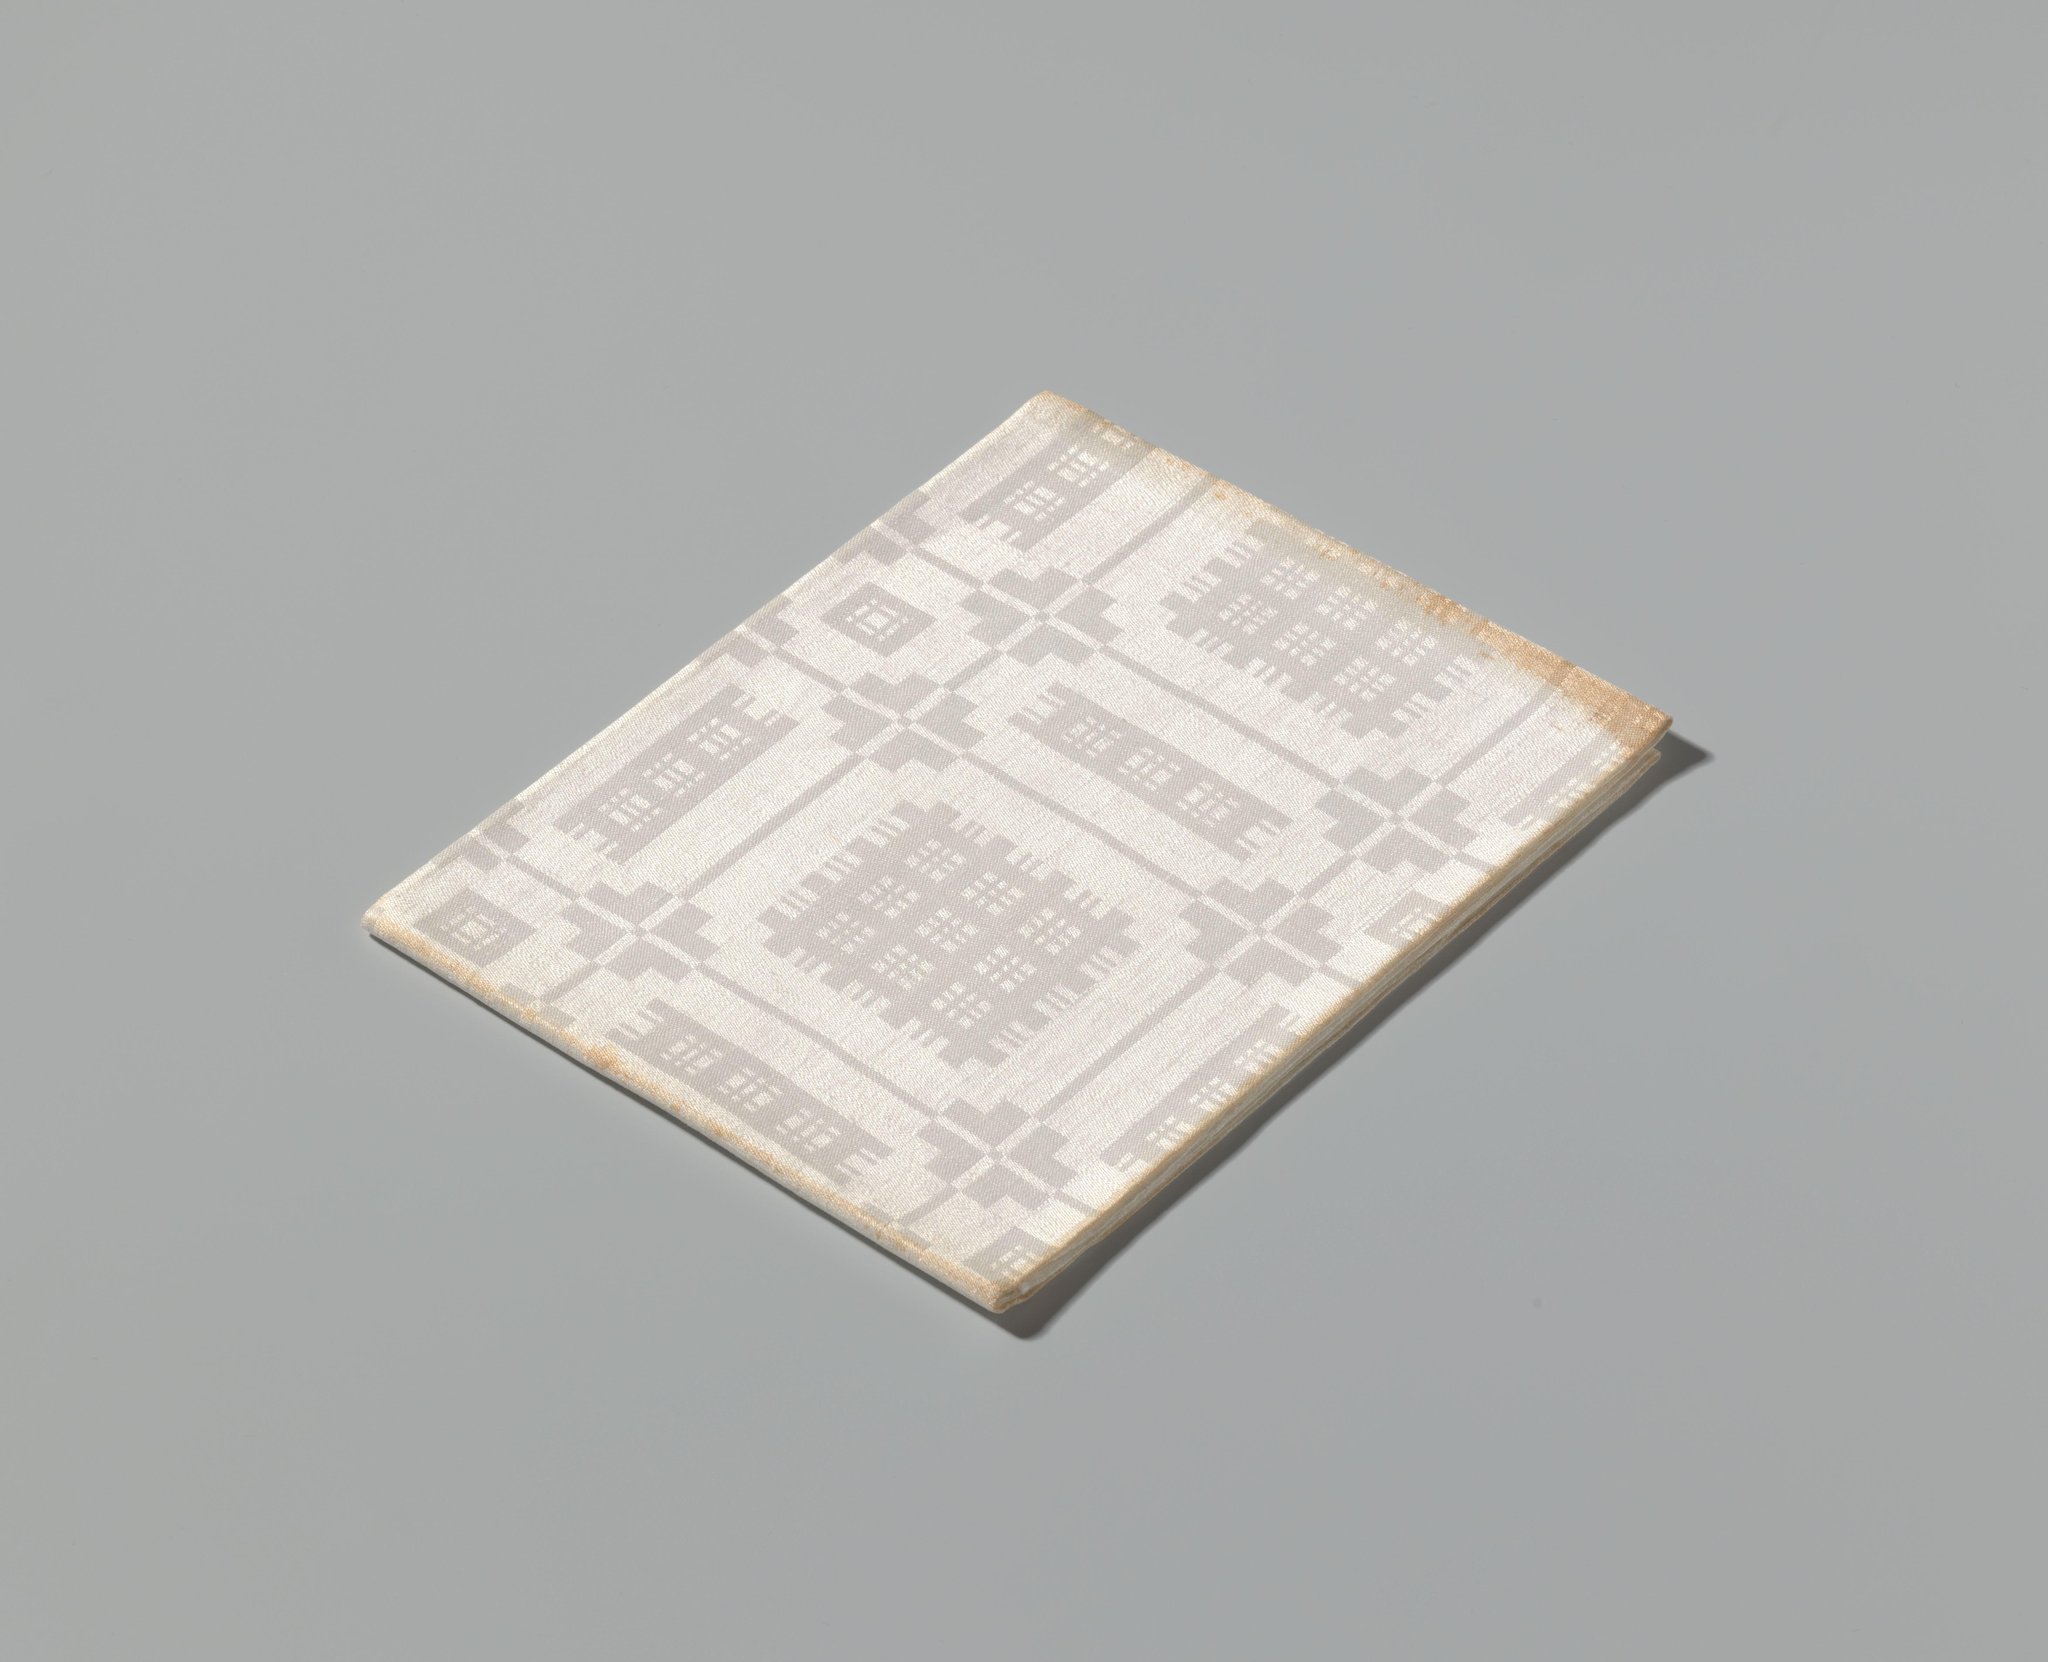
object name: napkin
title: Servet van linnen met pellenpatroon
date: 1700-1799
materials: linen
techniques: peeled fabric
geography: netherlands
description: wit linnen servet met een pellen patroon WH 2oonl